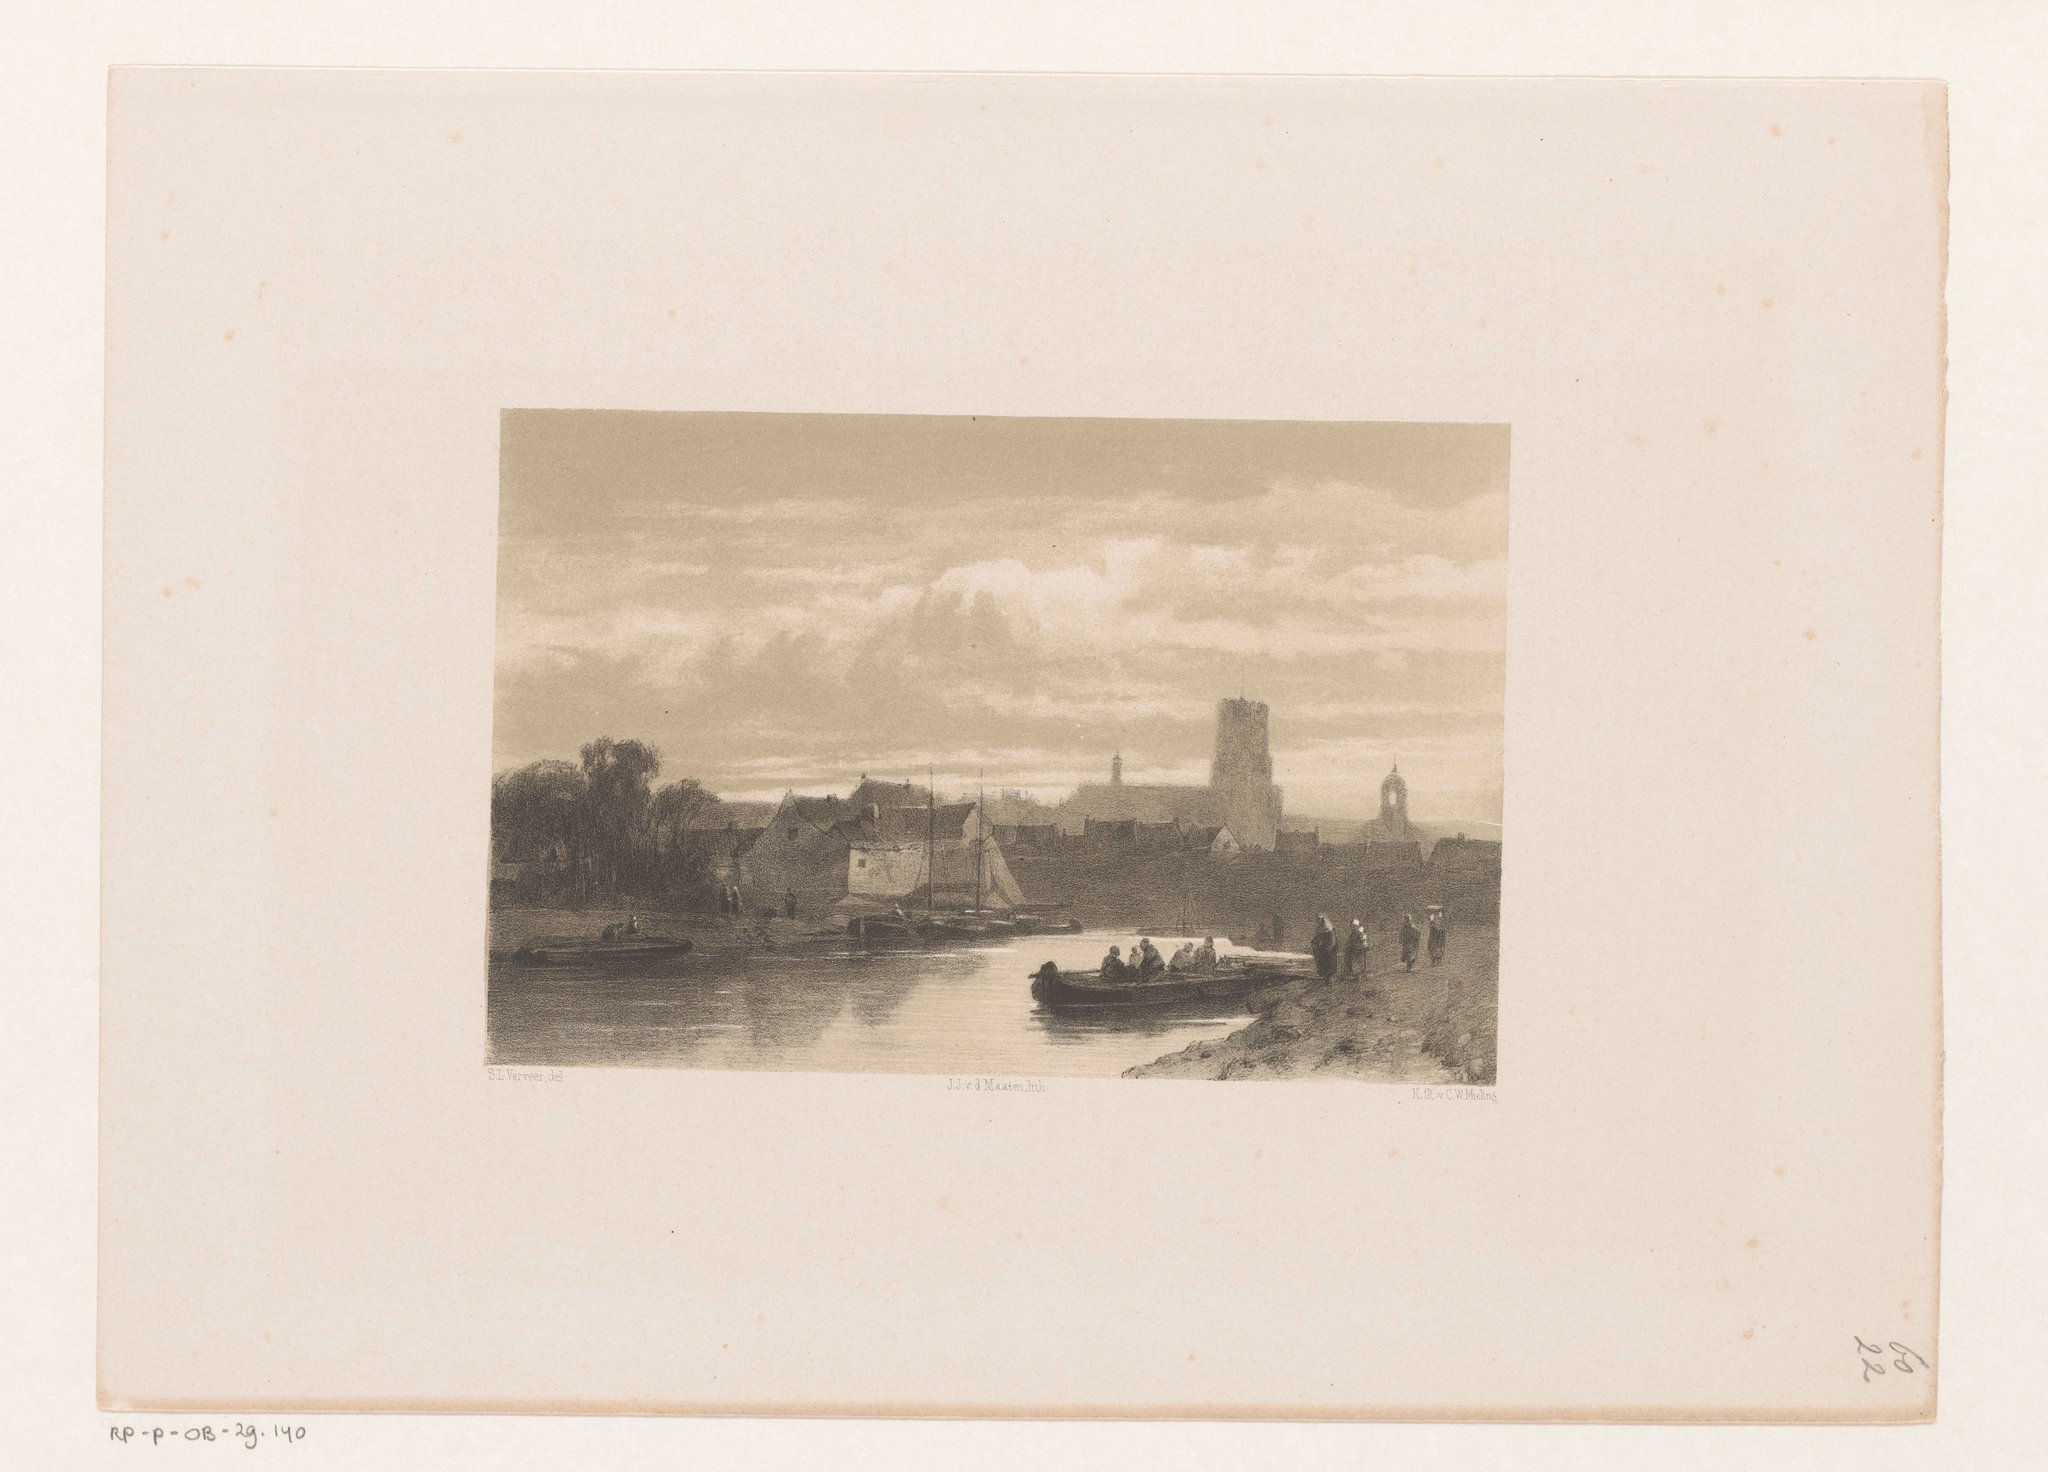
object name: print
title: Gezicht op haven en dijk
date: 1830-1865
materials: paper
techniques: tone lithography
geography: the hague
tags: harbour, church (exterior), dikes, levee (+ landscape with figures, staffage)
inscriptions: collector's mark: Lugt 2228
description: Rechts een boot met figuren en figuren op de kant. Achter de dijk huizen en een kerk.